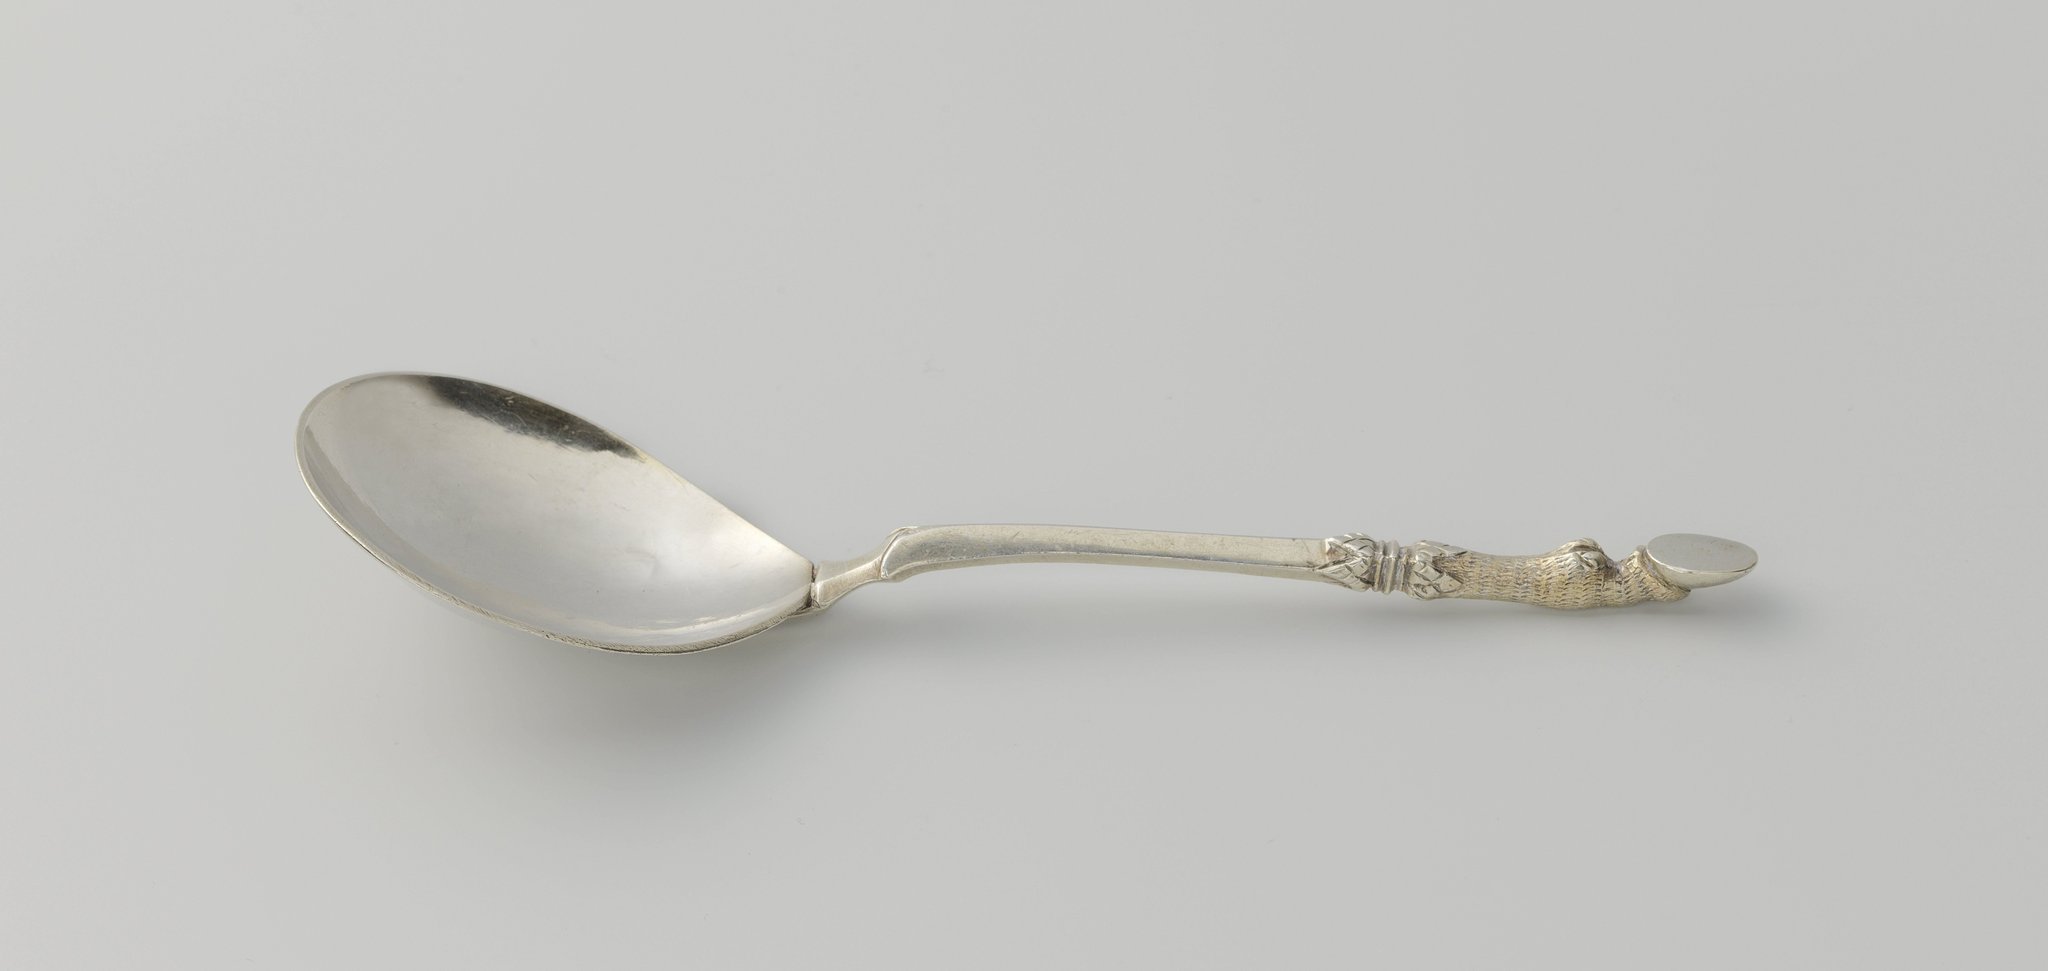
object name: spoon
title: Lepel met peervormige bak en steel bekroond met hoef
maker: Anonymous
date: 1650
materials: silver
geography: amsterdam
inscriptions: town mark, maker's mark, date letter: ‘T’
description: De peervormige bak is door middel van een naald verbonden met de bij de aanzet gebogen en ingesnoerde, en daarna rechte, vierzijdige steel. Het korte, ingesnoerde gedeelte is aan de bovenzijde gefacetteerd. Daar, waar het vierzijdige gedeelte zich splitst, wordt de indruk gewekt dat het gefacetteerde deel aansluit. De steel is door een aan beide zijden door een krans van gegraveerde bladmotieven afgesloten profiel gescheiden van de bekroning in de vorm van een bokkenpoot met een naturalistisch bewerkt oppervlak.